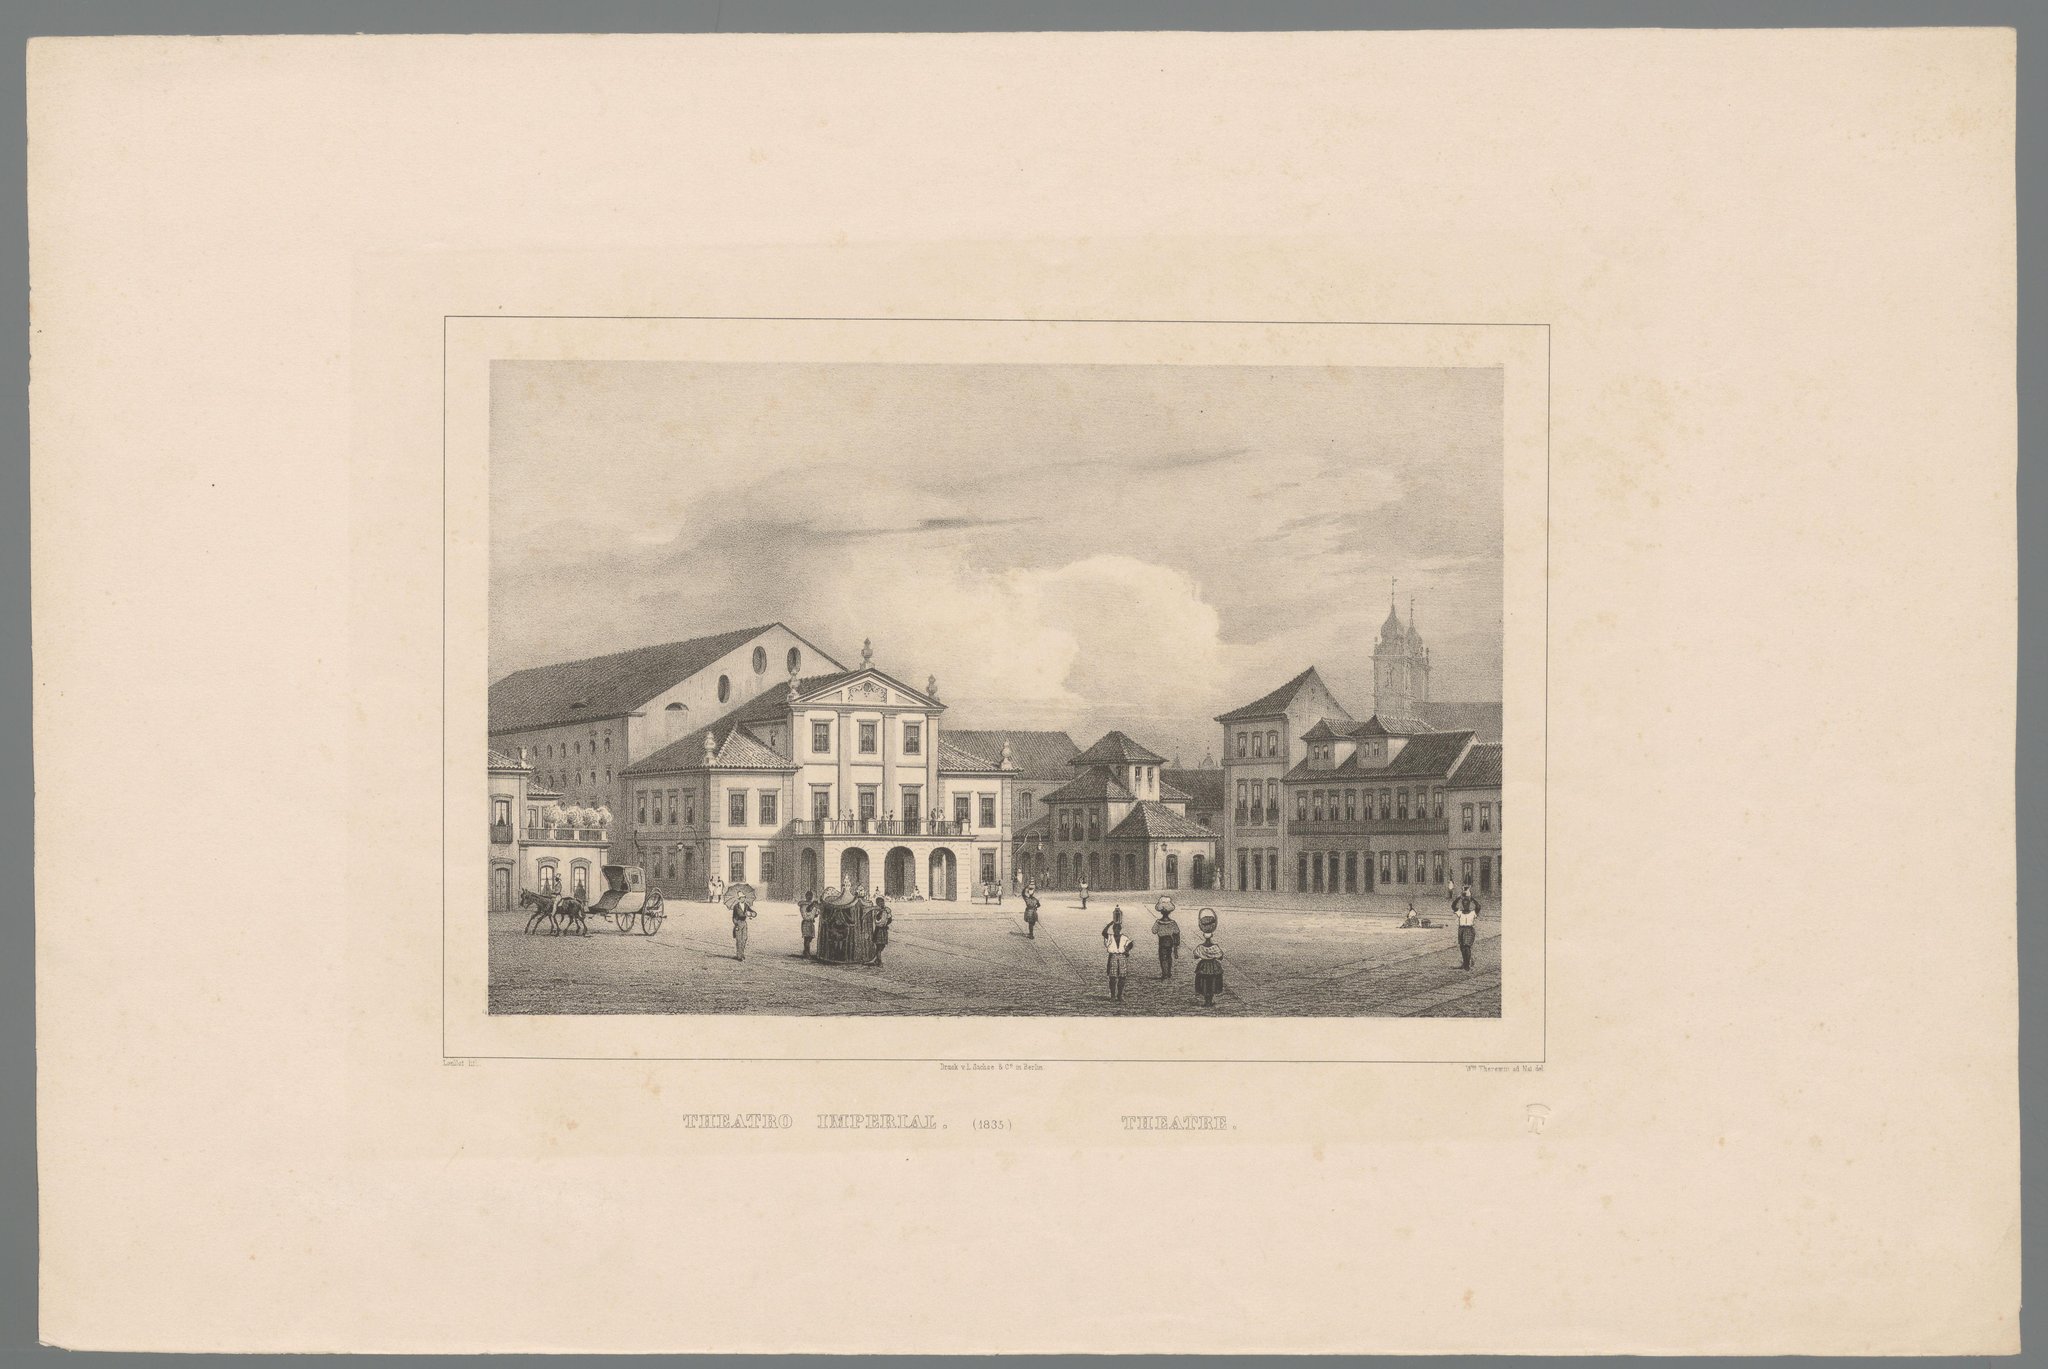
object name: print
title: Gezicht op het Keizerlijk Paleis van Rio de Janeiro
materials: paper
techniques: lithograph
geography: berlin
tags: city-view in general; 'veduta', palace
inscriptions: collector's mark: Lugt 2228, check stamp: ‘T’